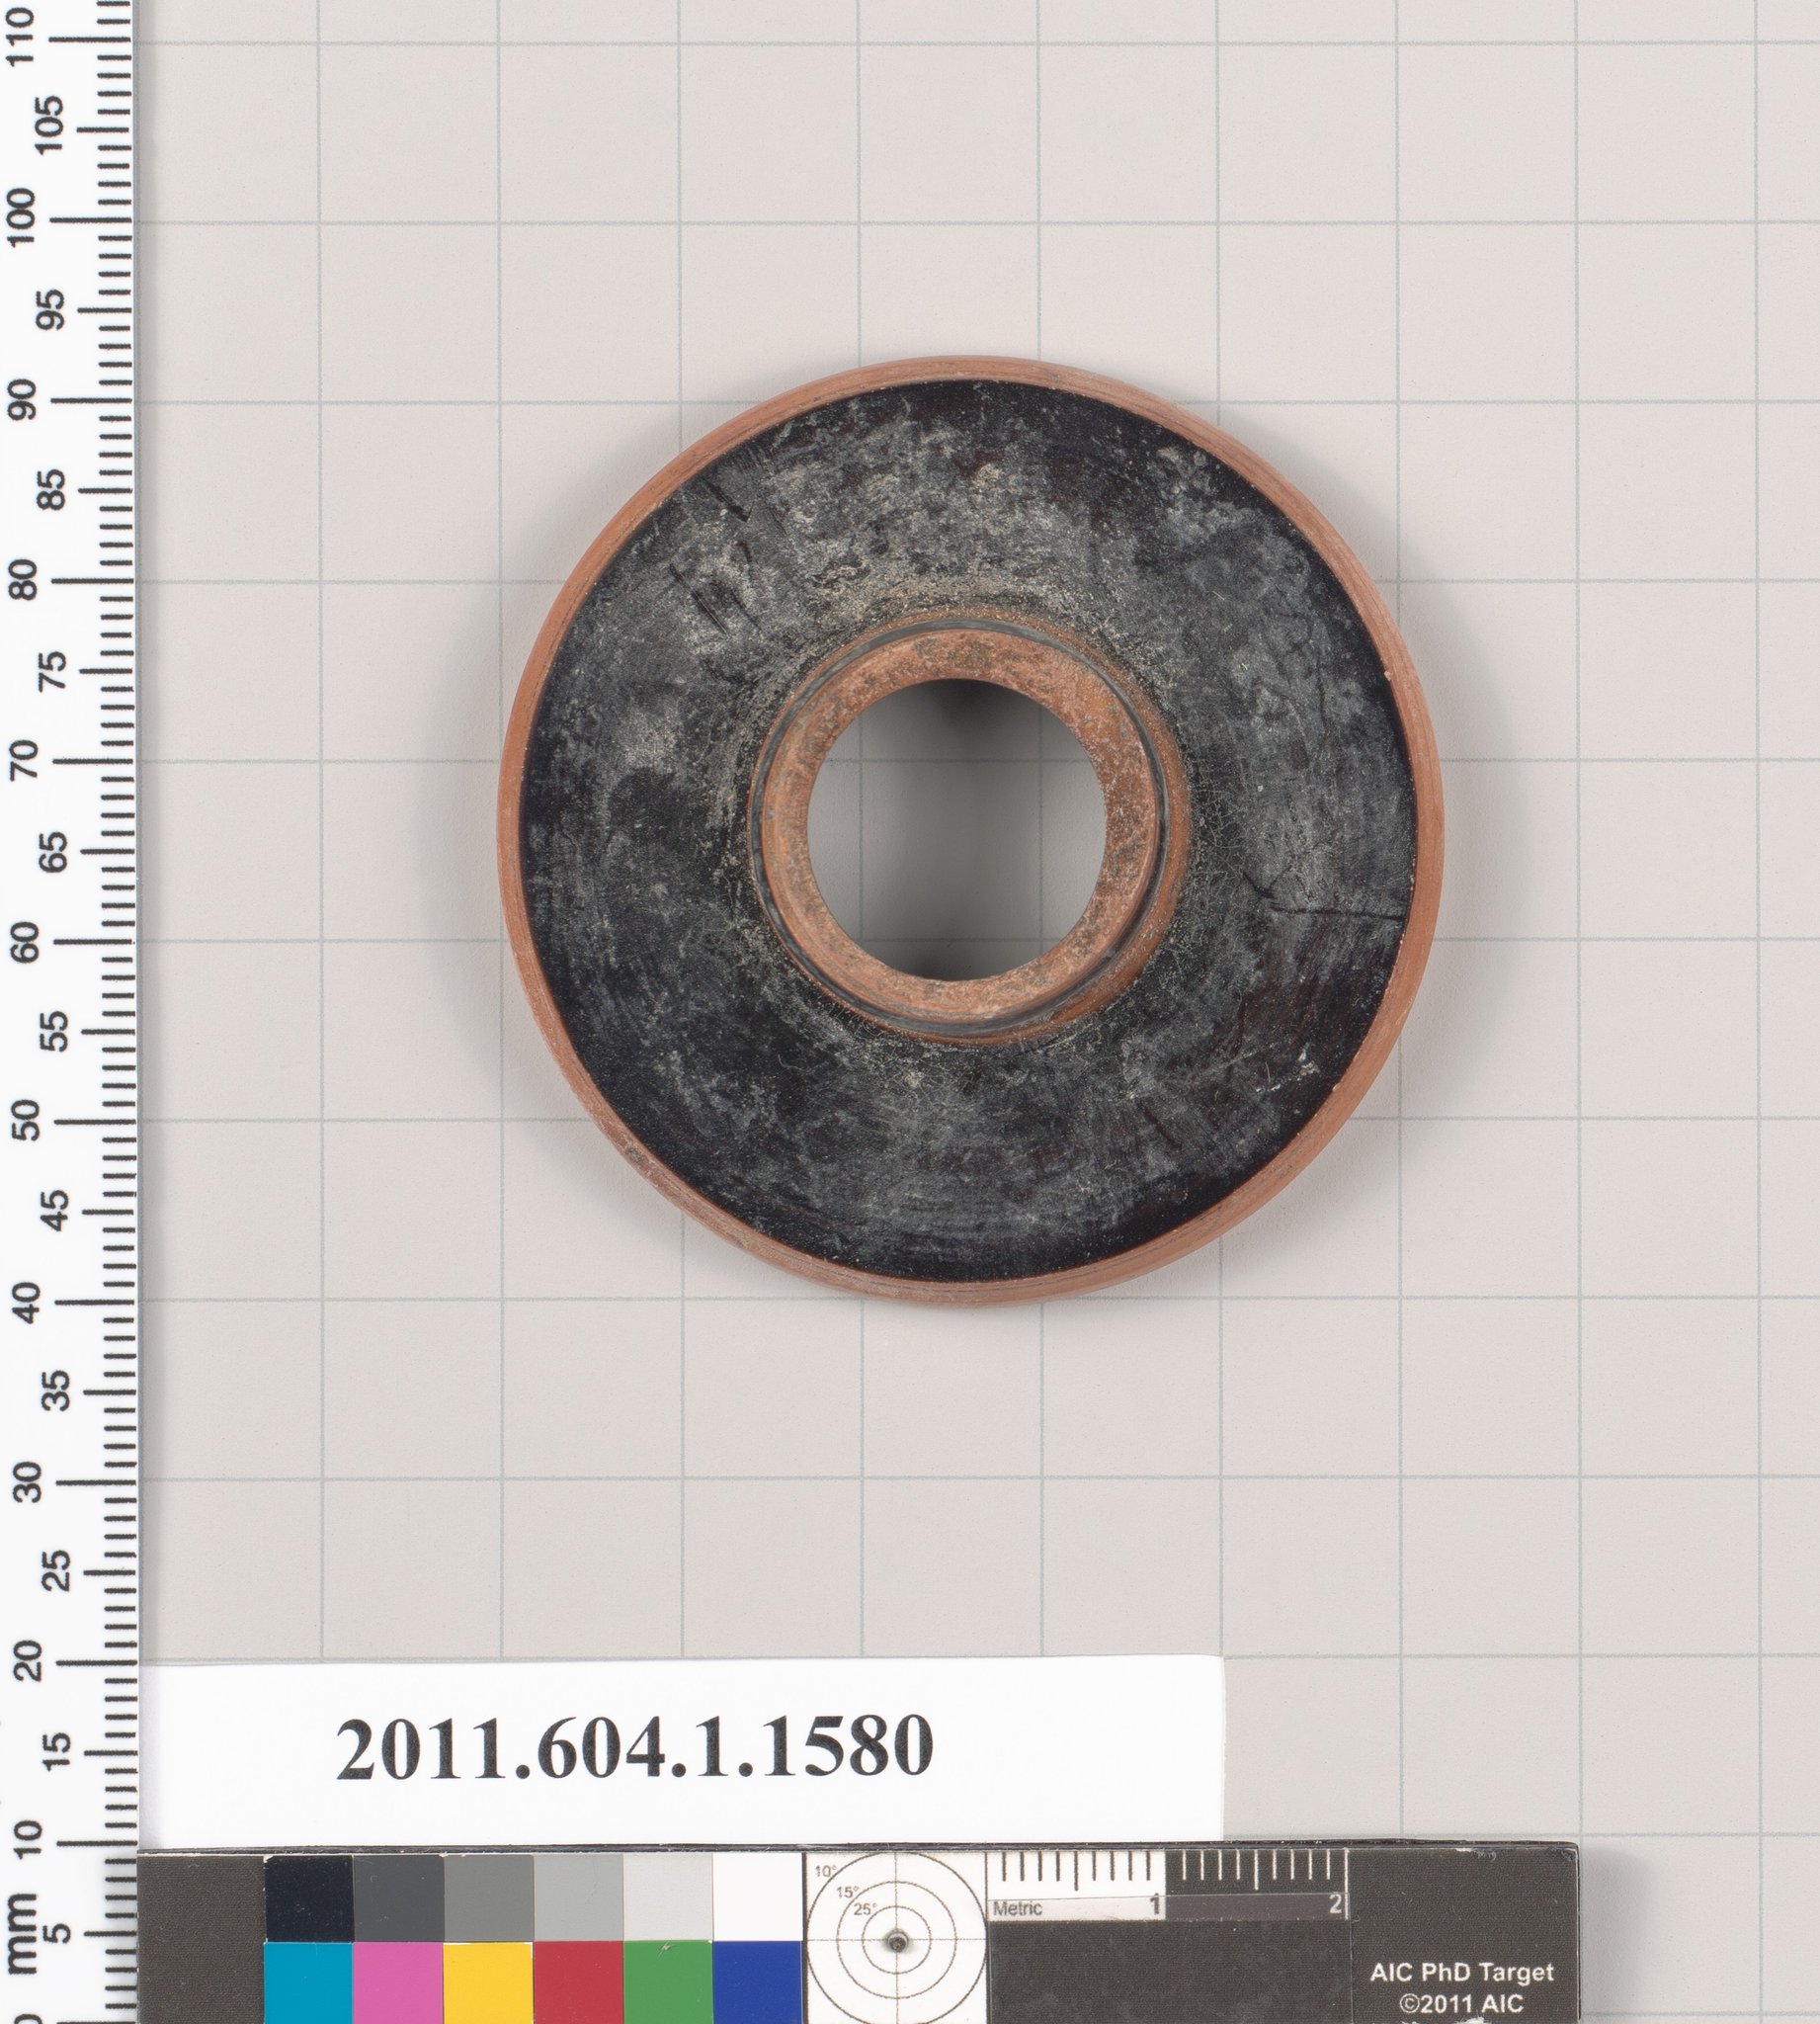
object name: kylix fragment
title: Terracotta fragment of a kylix? (drinking cup)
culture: greek, attic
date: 500-401 BCE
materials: terracotta